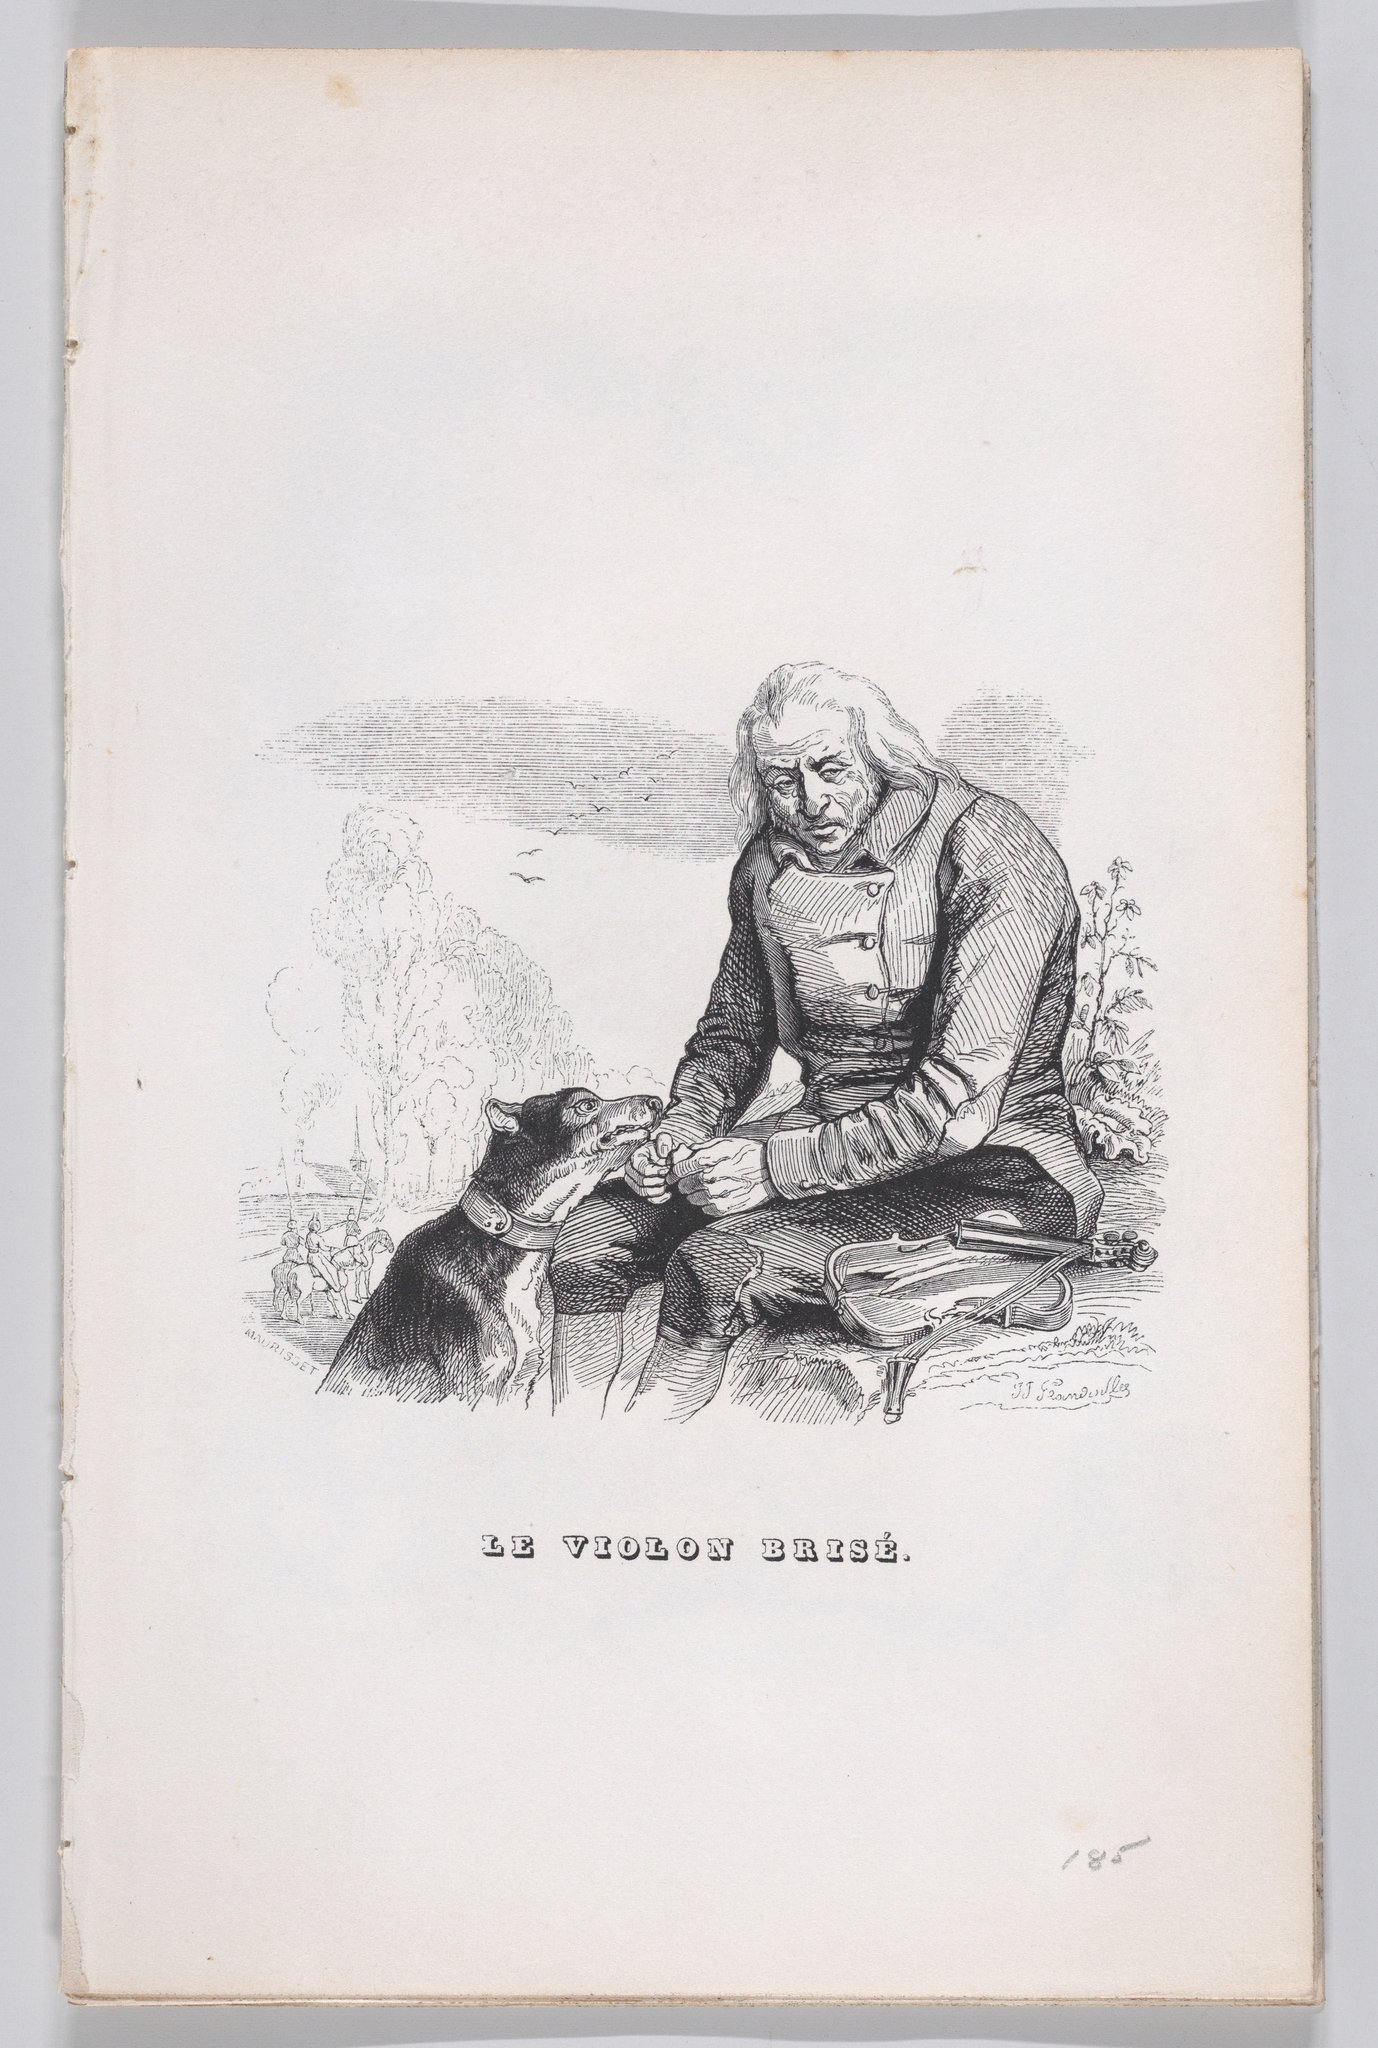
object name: print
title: The Broken Violin, from "The Complete Works of Béranger"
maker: j. j. grandville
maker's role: illustrator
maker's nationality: french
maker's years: 1803-1847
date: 1836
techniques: engraving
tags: men,violins,dogs